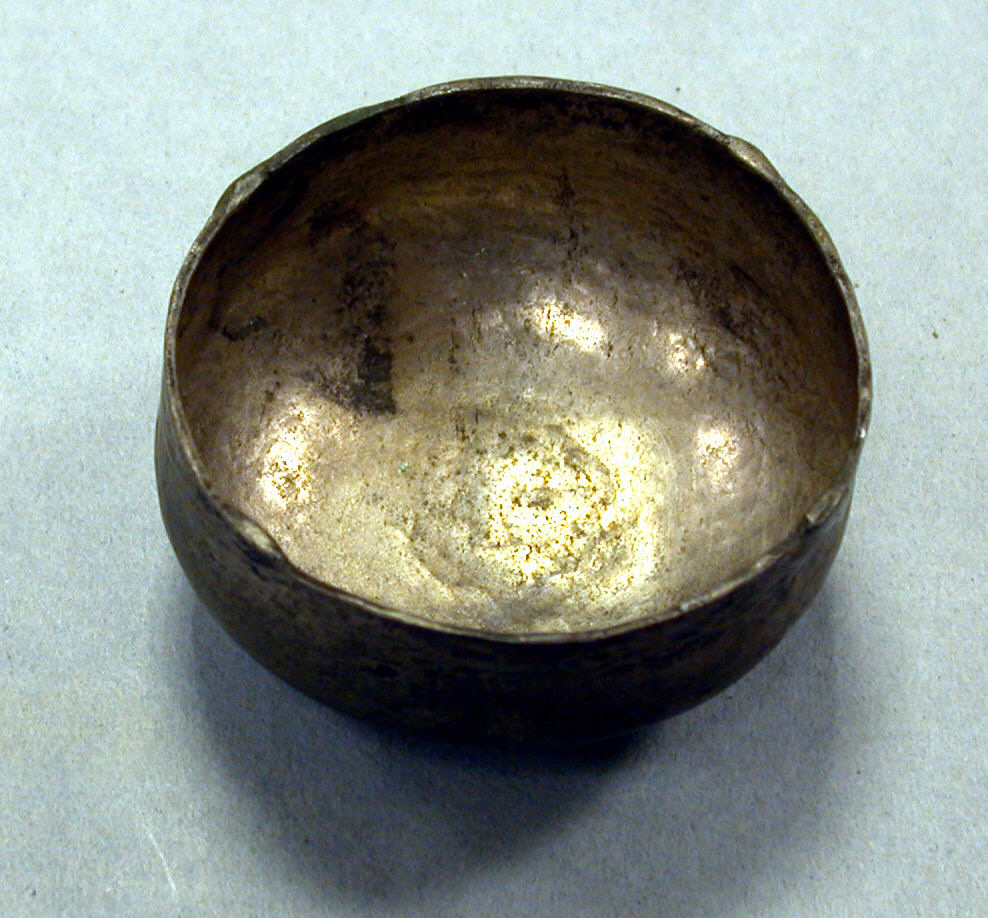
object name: ornament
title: Cup-shaped Miniature Ornament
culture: peruvian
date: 701-1566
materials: gilt, silver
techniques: hammering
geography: peru